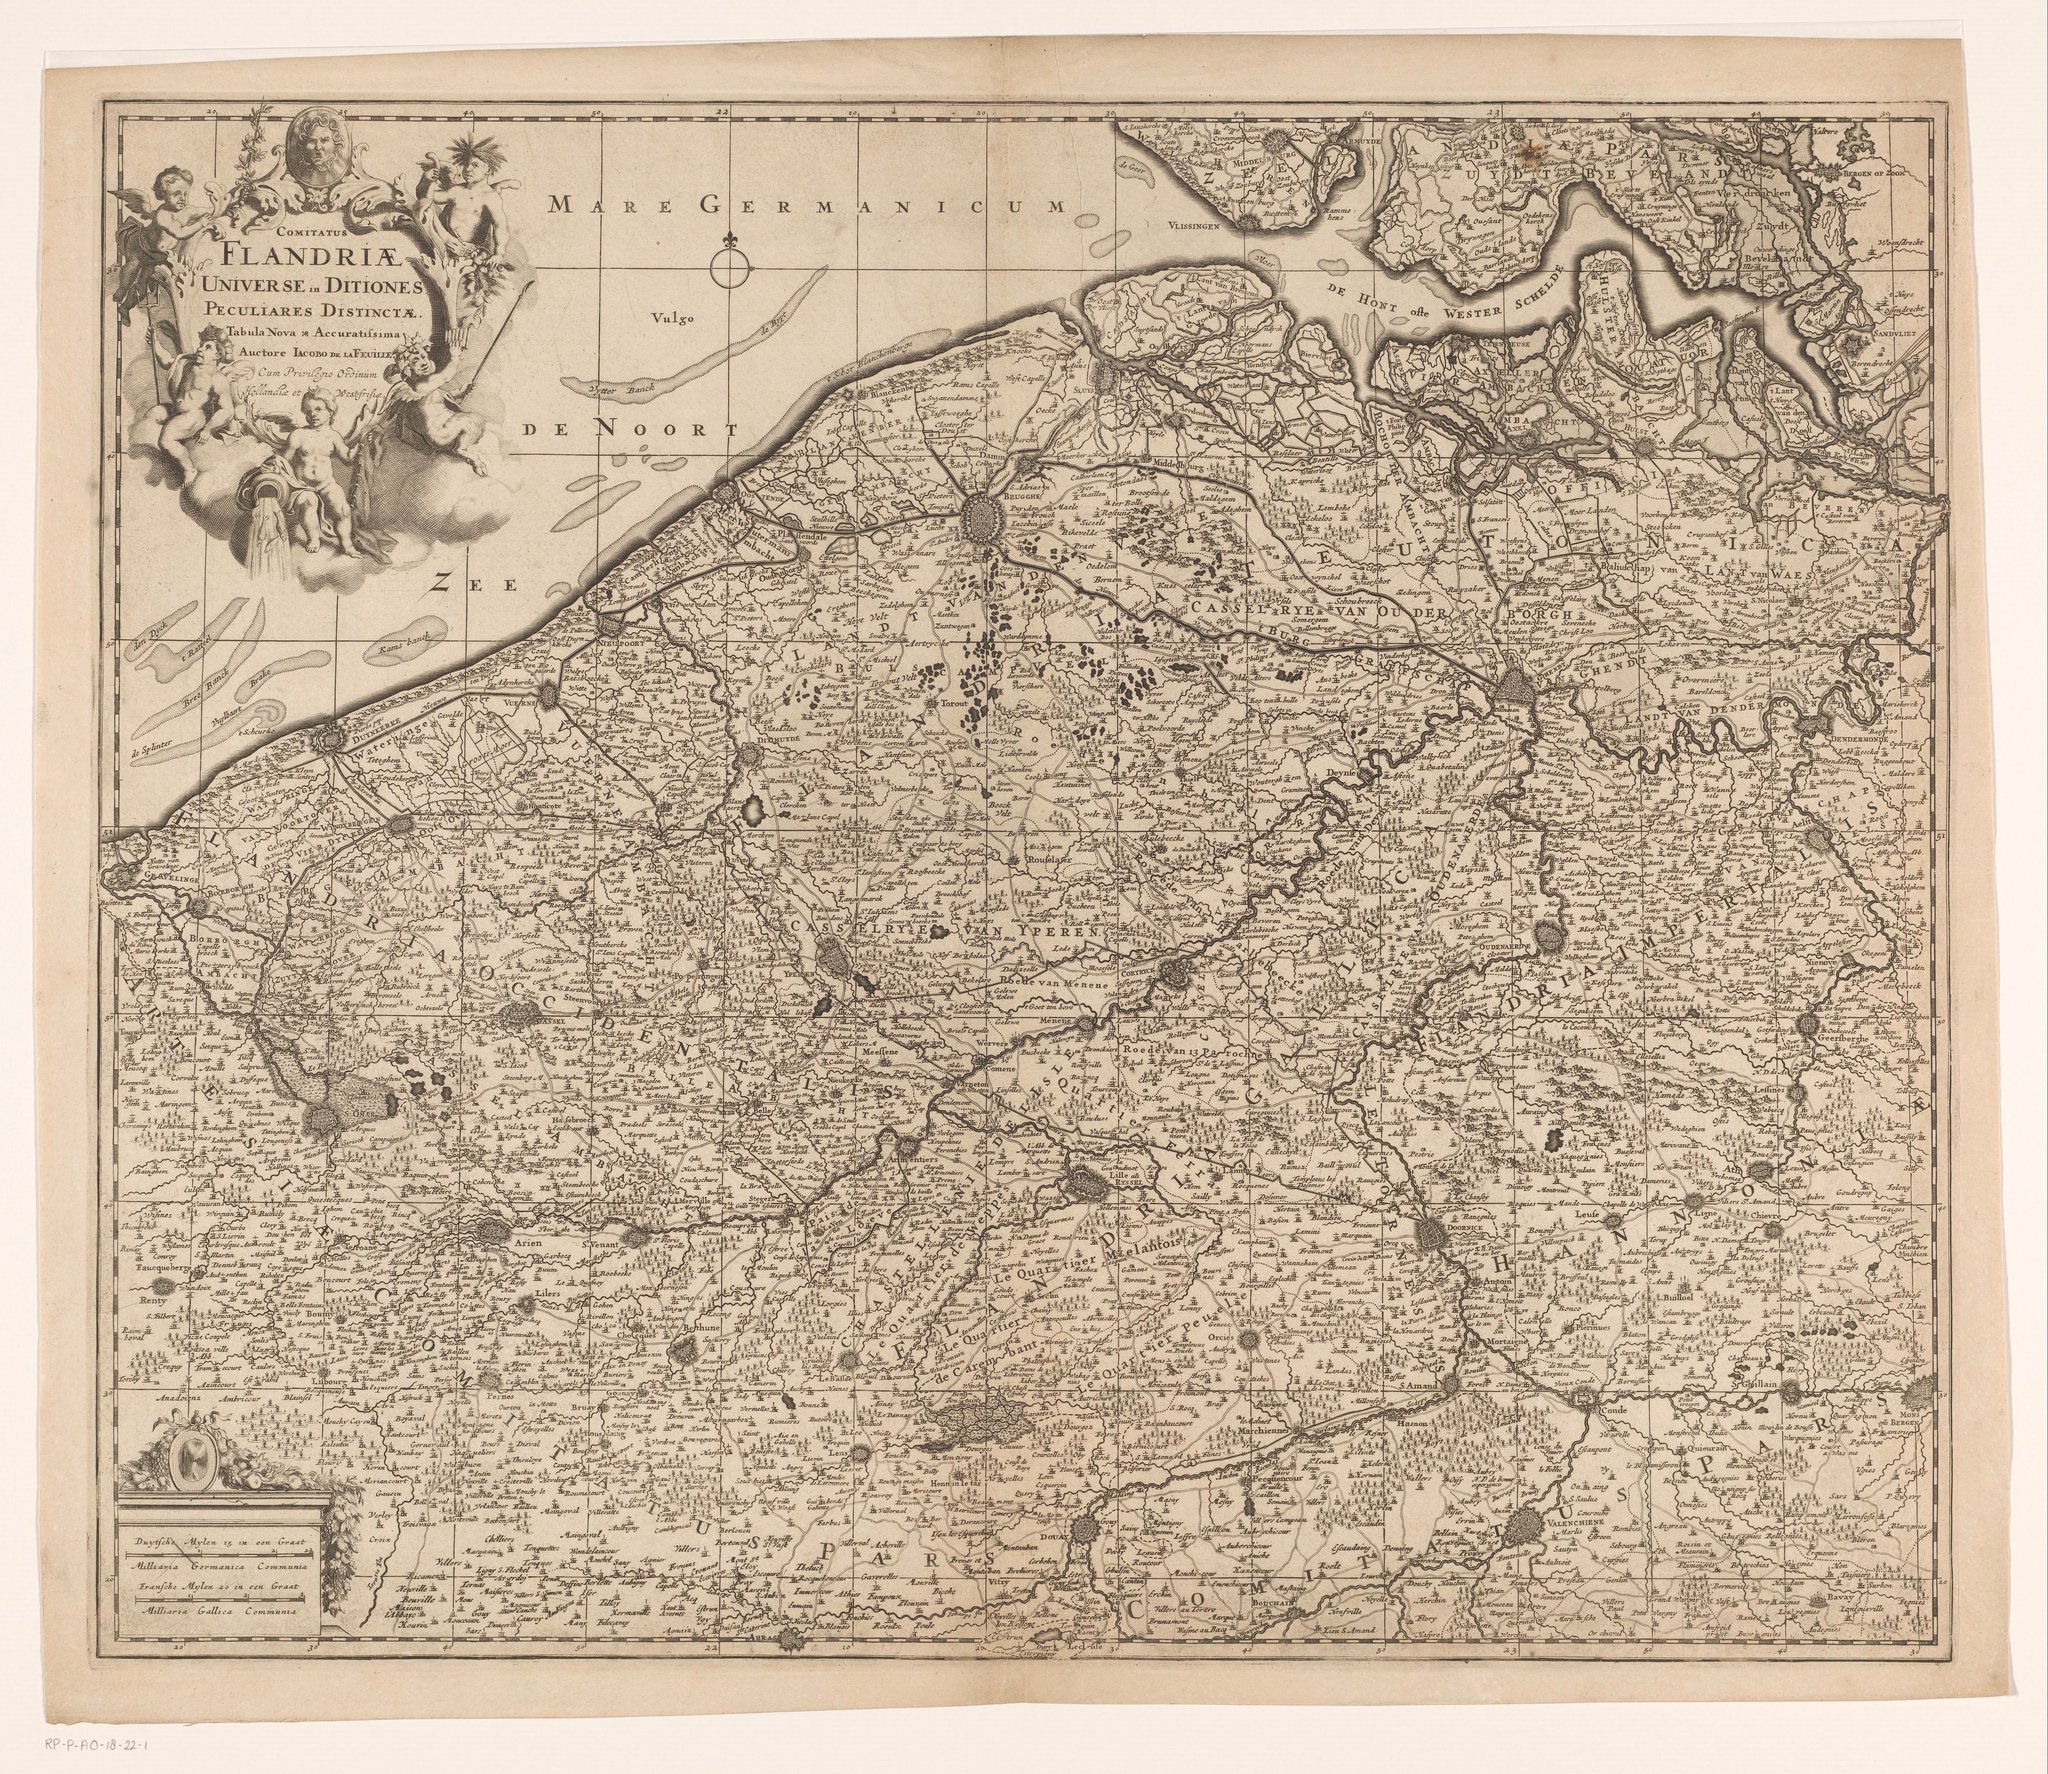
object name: map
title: Kaart van het graafschap Vlaanderen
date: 1678-1719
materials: paper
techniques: engraving, etching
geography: amsterdam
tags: attributes of pan, 'cornucopia', horn of plenty, maps of separate countries or regions, river personified, 'fiumi' (ripa), attributes of neptune: trident, cupids: 'amores', 'amoretti', 'putti'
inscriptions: collector's mark: Lugt 195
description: Kaart van het graafschap Vlaanderen. Linksboven de titelcartouche met daaromheen putti met de attributen van verschillende Griekse goden. Linksonder een cartouche met twee schaalstokken: 2 1/2 Duytsche Mylen 15 in een Graat / 3 Fransche Mylen 20 in een Graat. De kaart is voorzien van een coördinaten-net en een gradenverdeling langs de randen.